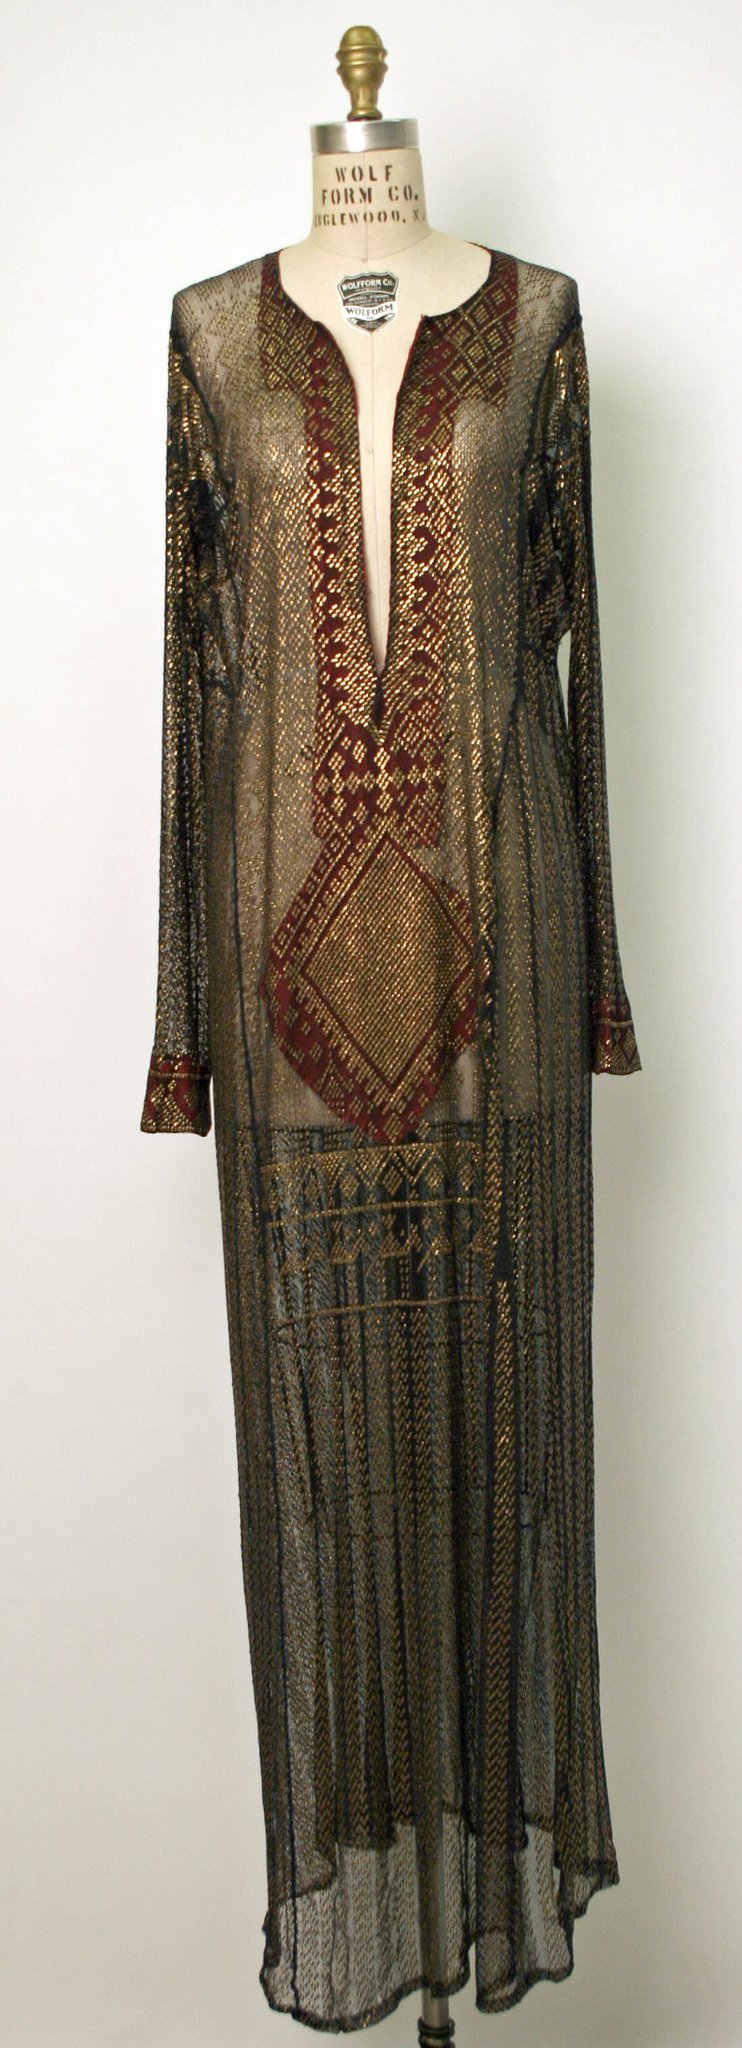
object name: dress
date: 1801-1900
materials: cotton, metal thread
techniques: embroidery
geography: egypt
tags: dresses